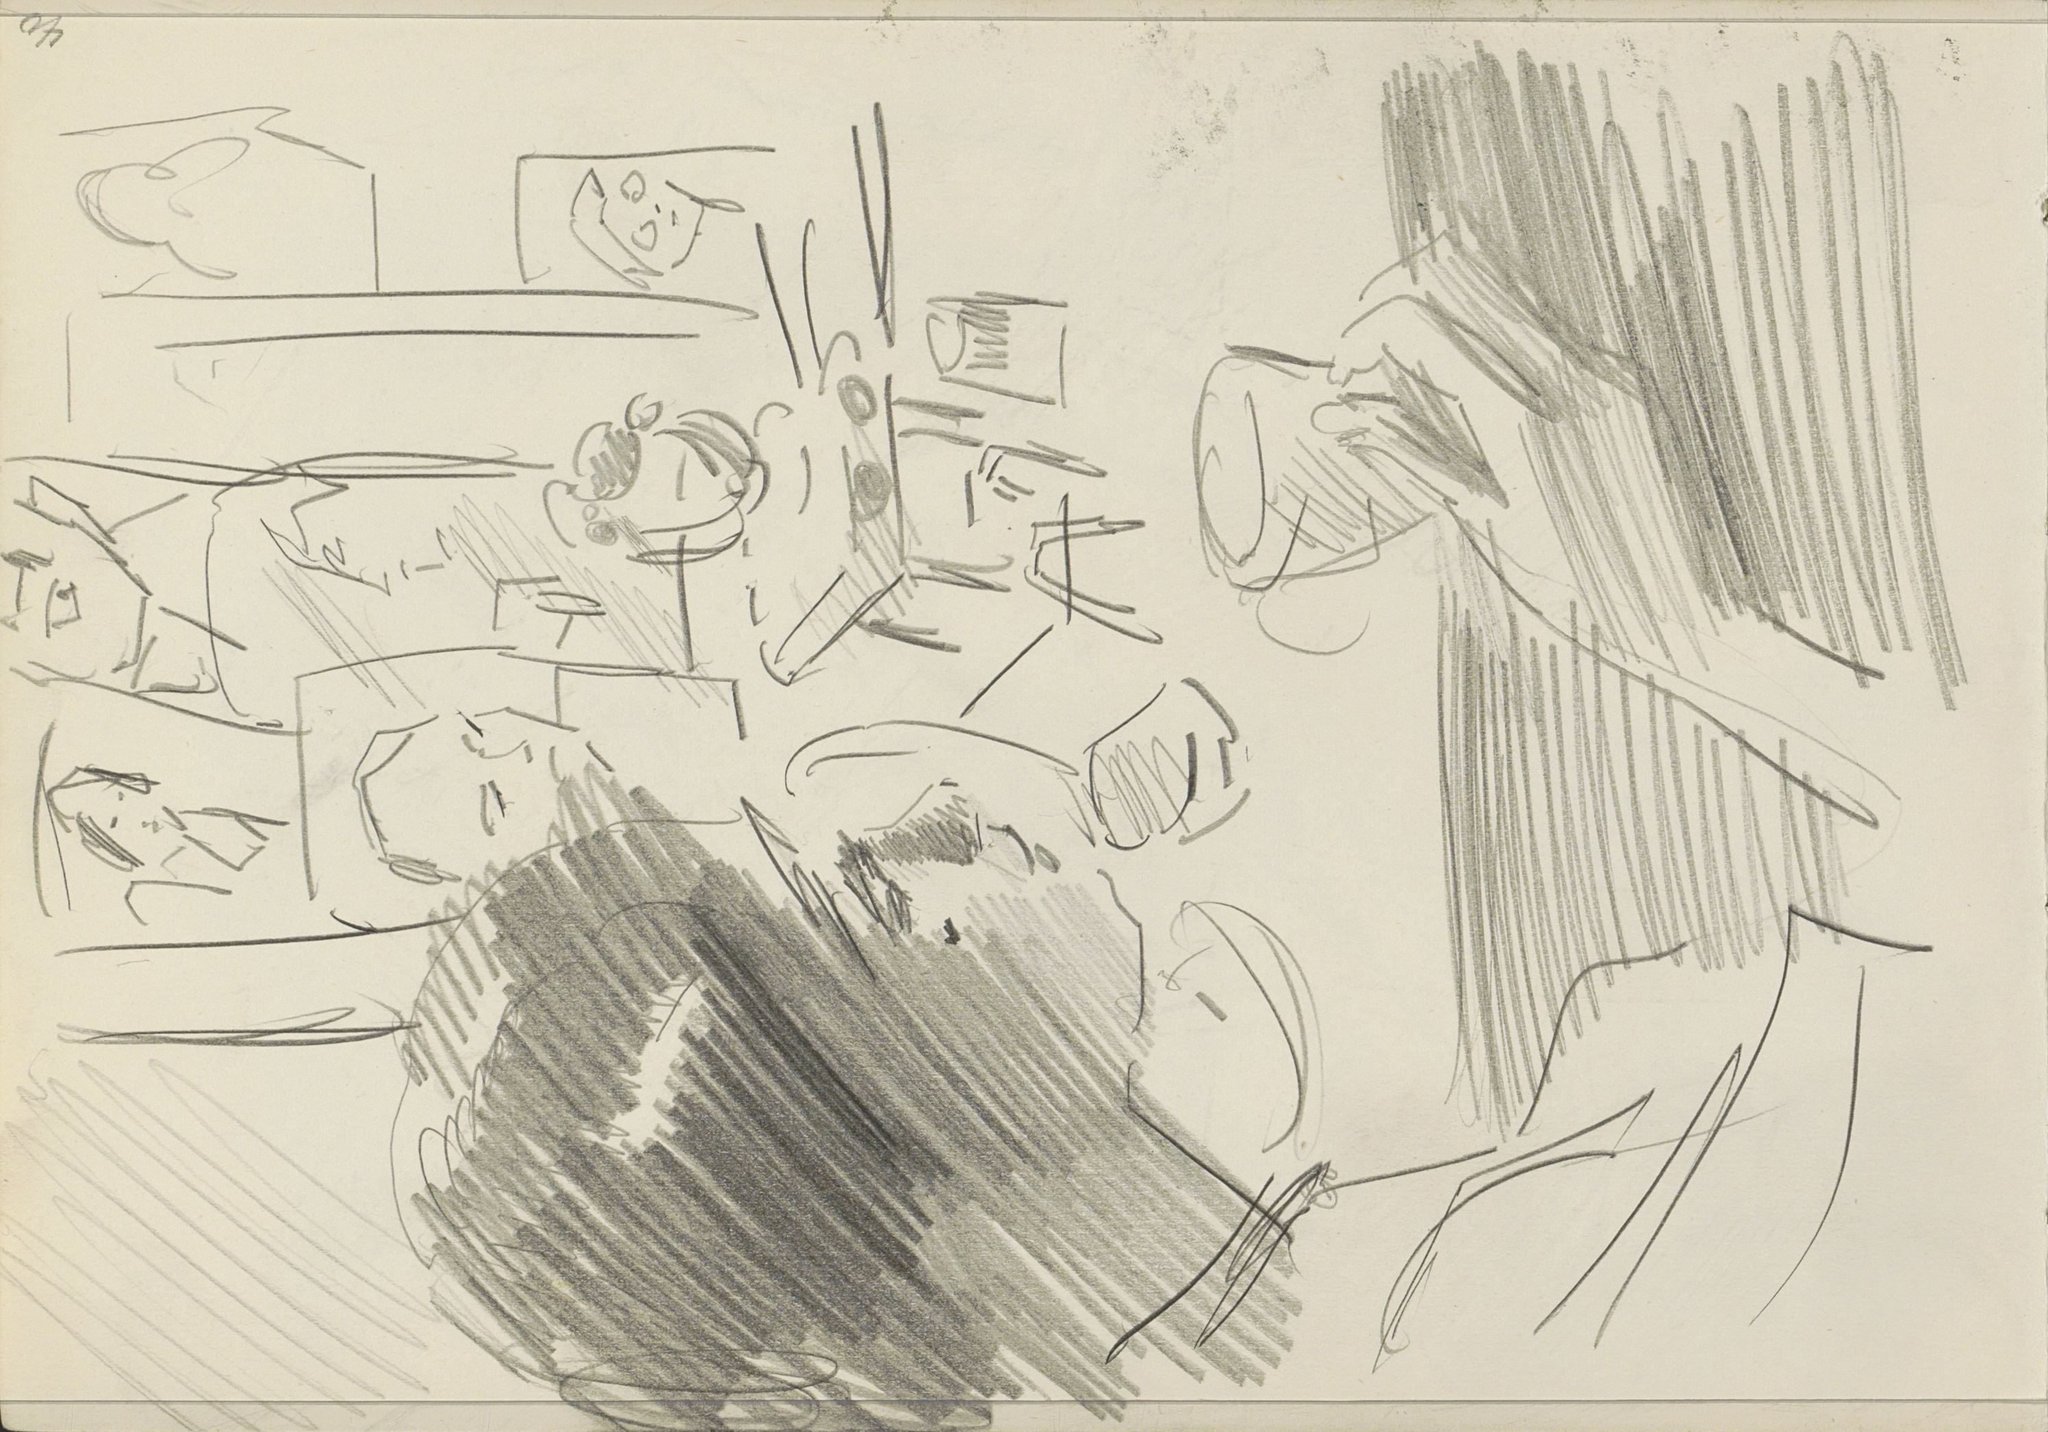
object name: sketchbook leaf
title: Artieste met een kopje in een kleedkamer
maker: isaac israels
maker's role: draughtsman, painter, print maker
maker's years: 1865-1934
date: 1915-1934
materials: paper, pencil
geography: the hague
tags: adult woman, dressing-room ~ stage, cup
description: Op de achtergrond posters of foto's. Blad 8 verso uit schetsboek XXV met 23 bladen.